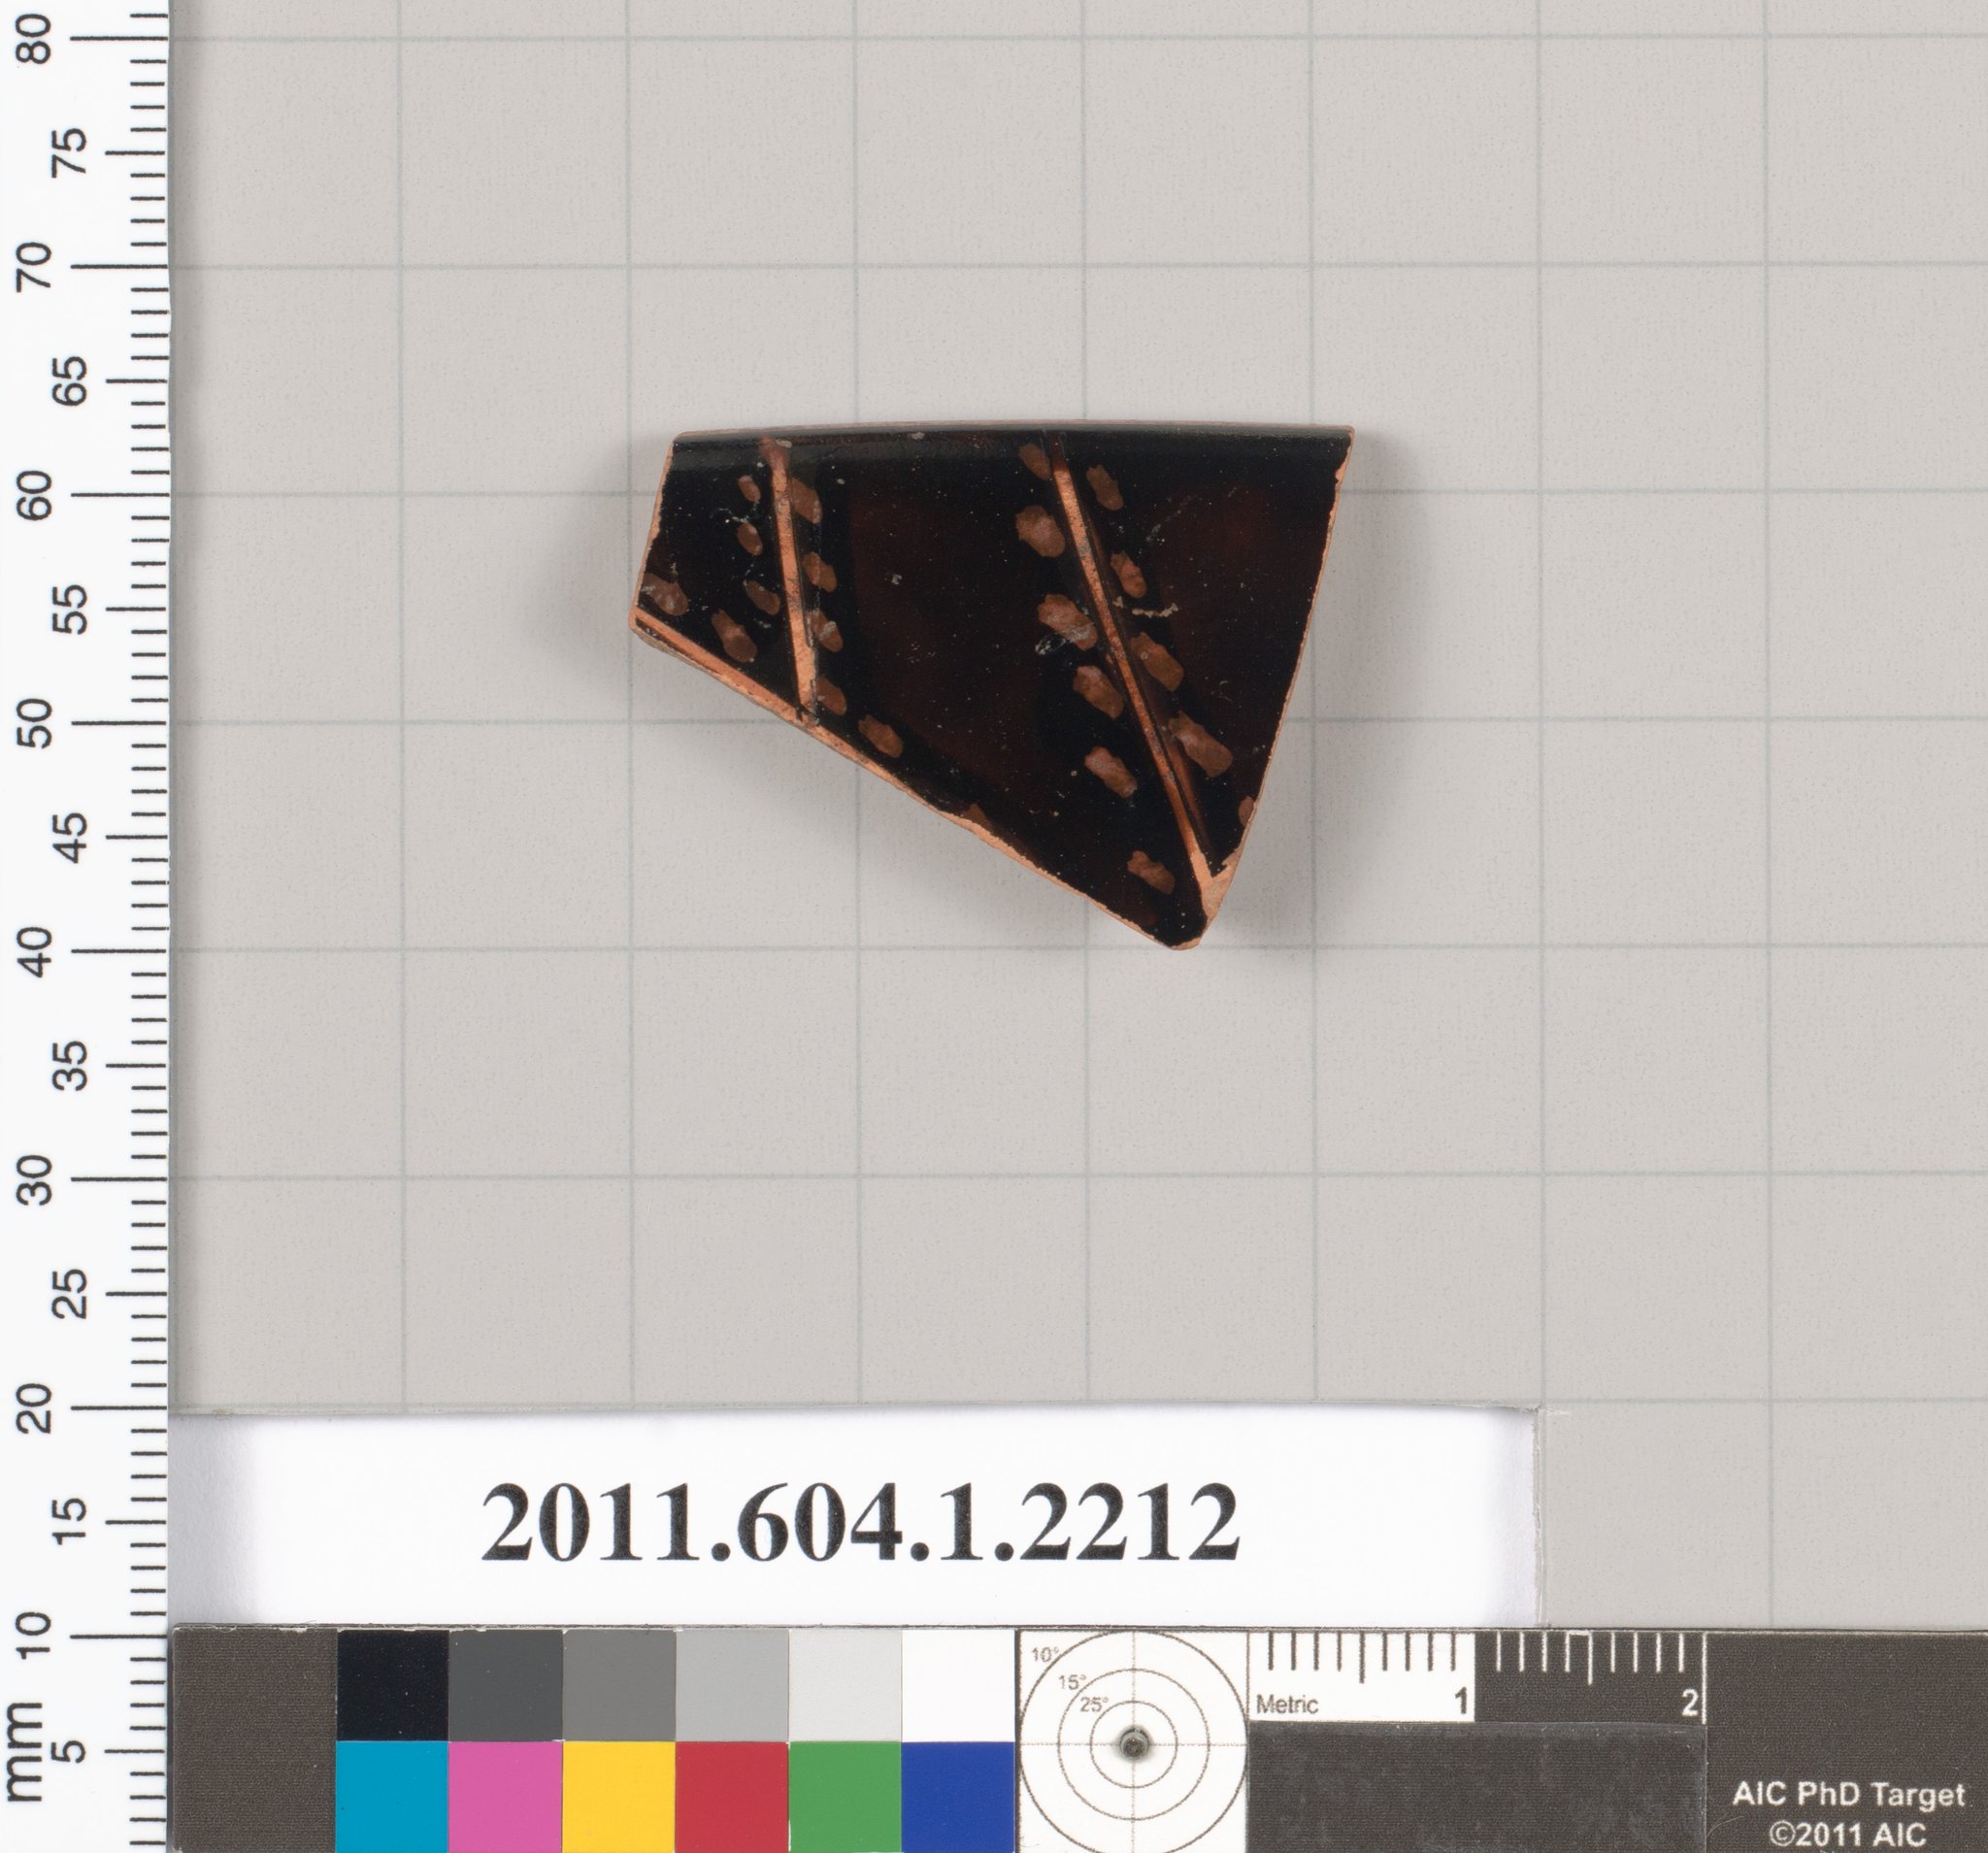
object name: kylix fragment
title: Terracotta rim fragment of a kylix (drinking cup)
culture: greek, attic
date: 475-451 BCE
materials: terracotta